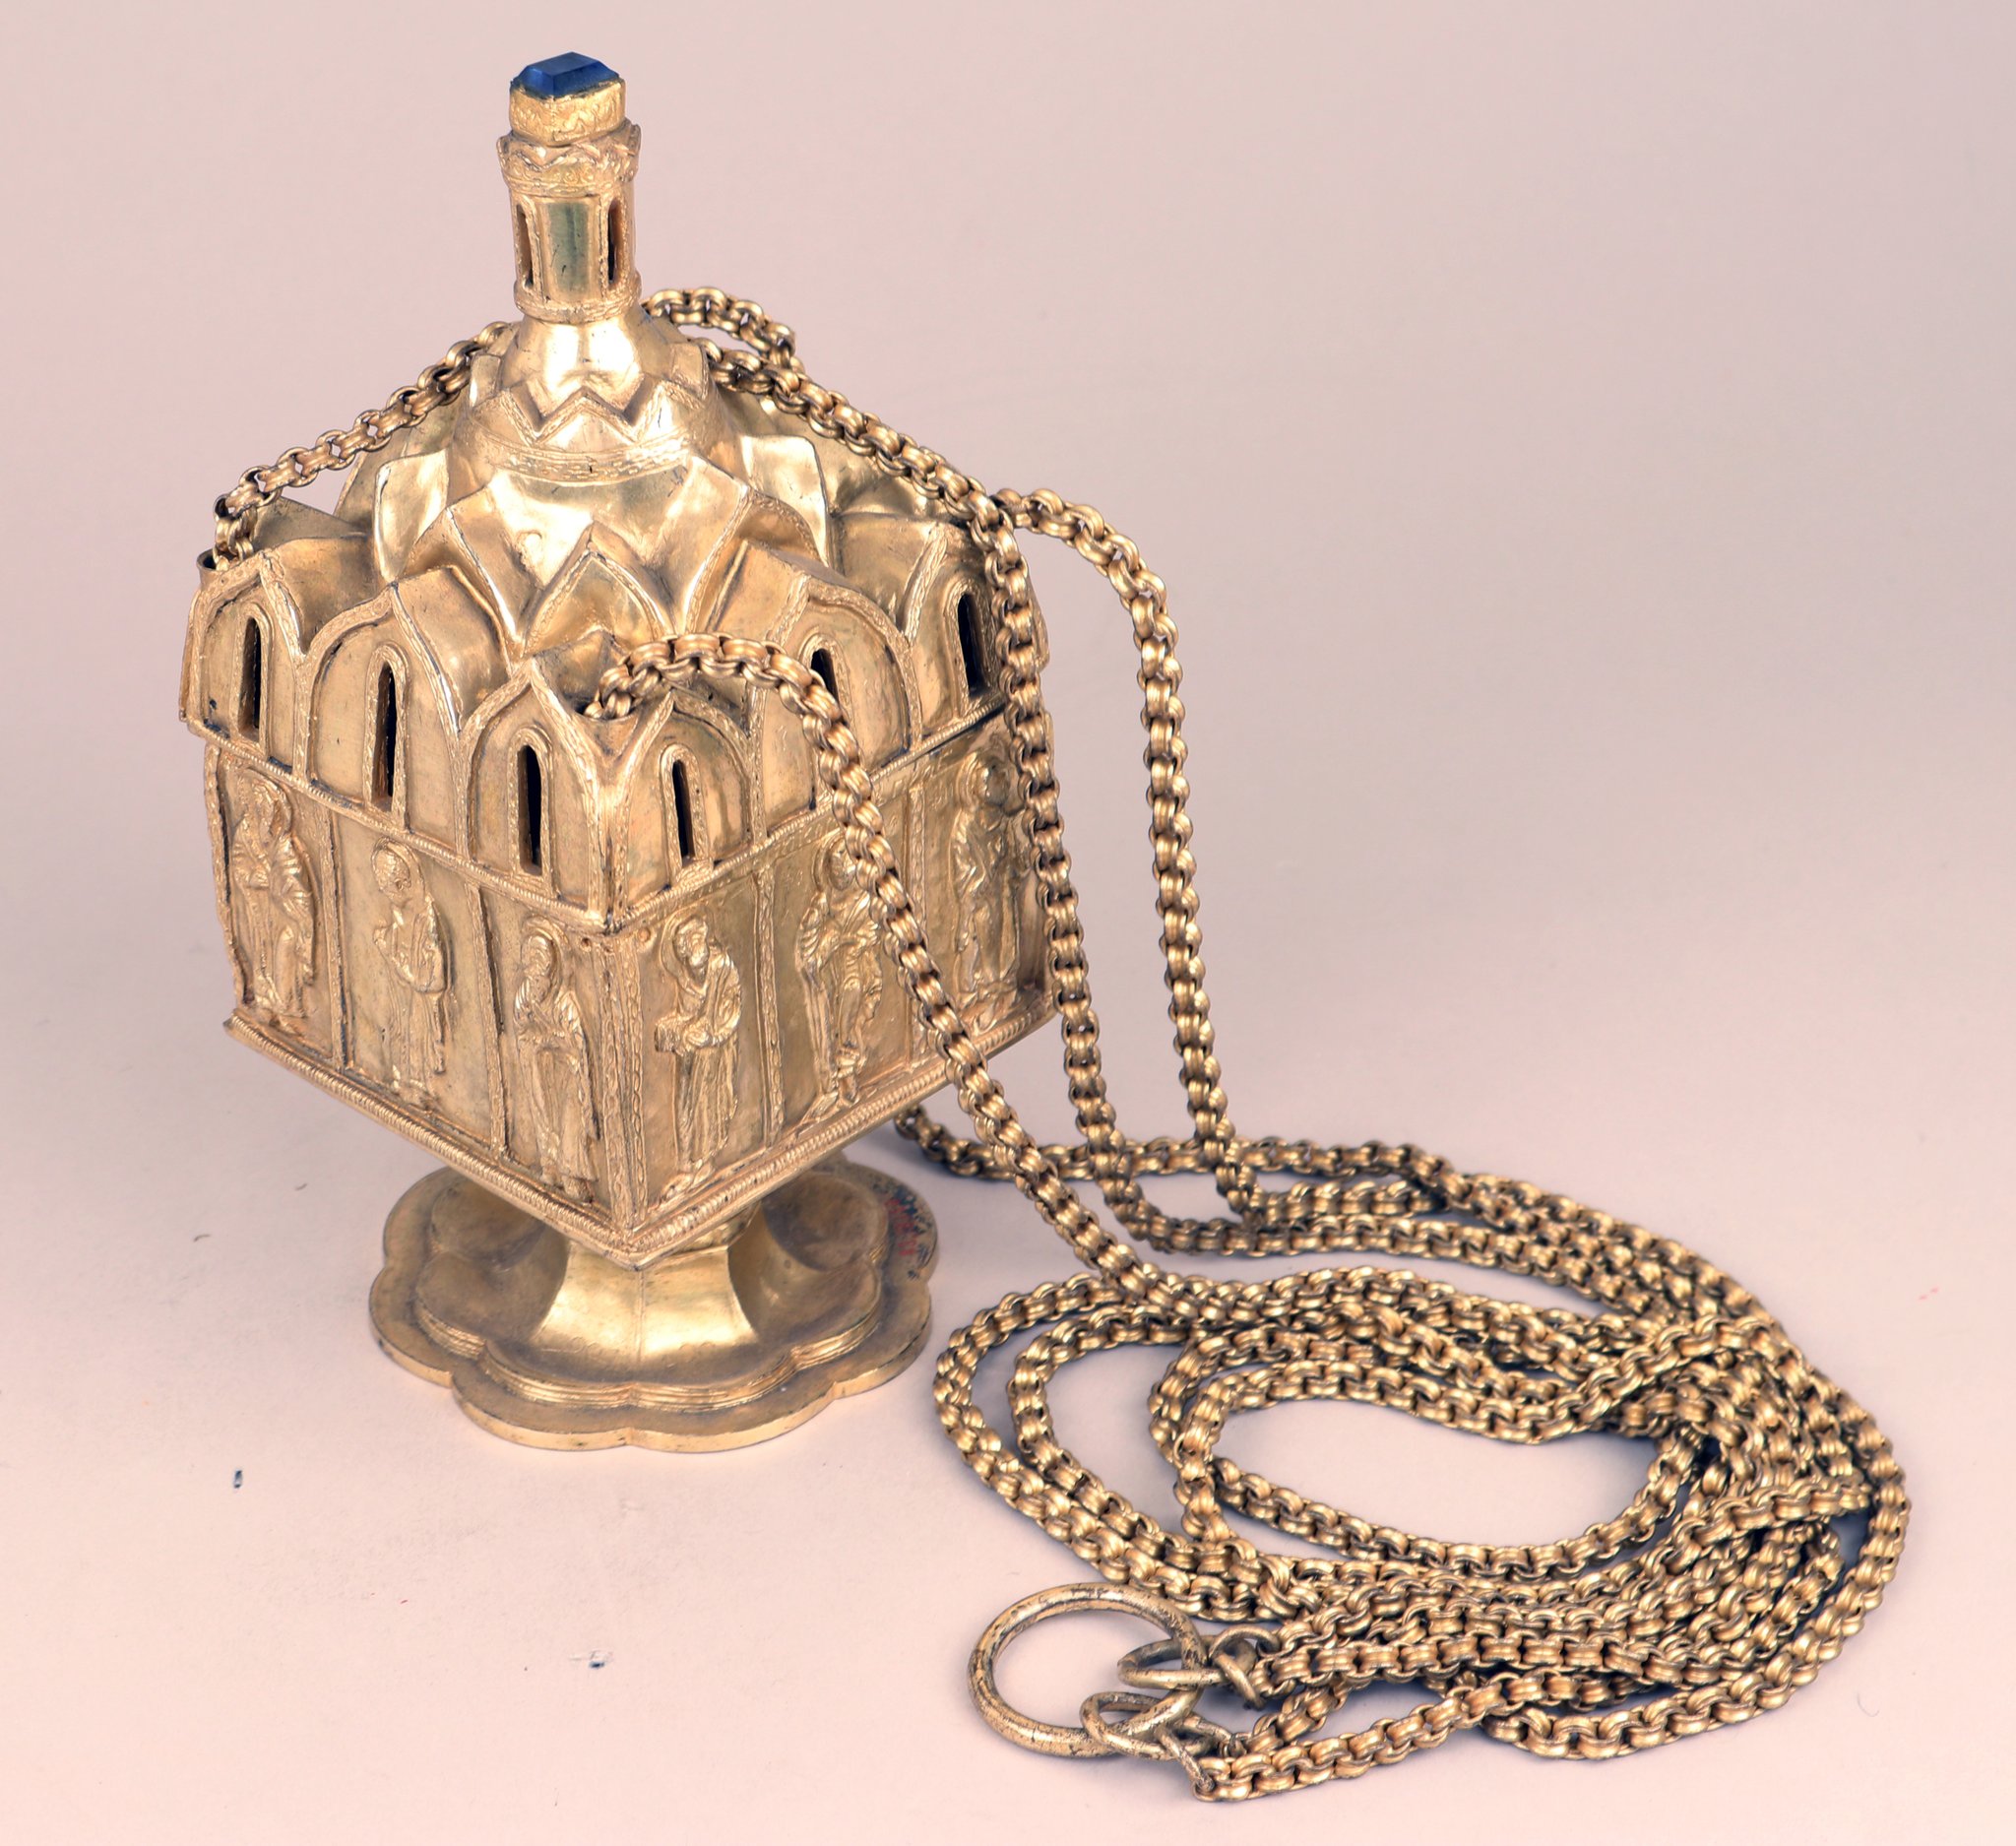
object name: censer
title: Censer with chain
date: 1801-1900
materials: metal, silver